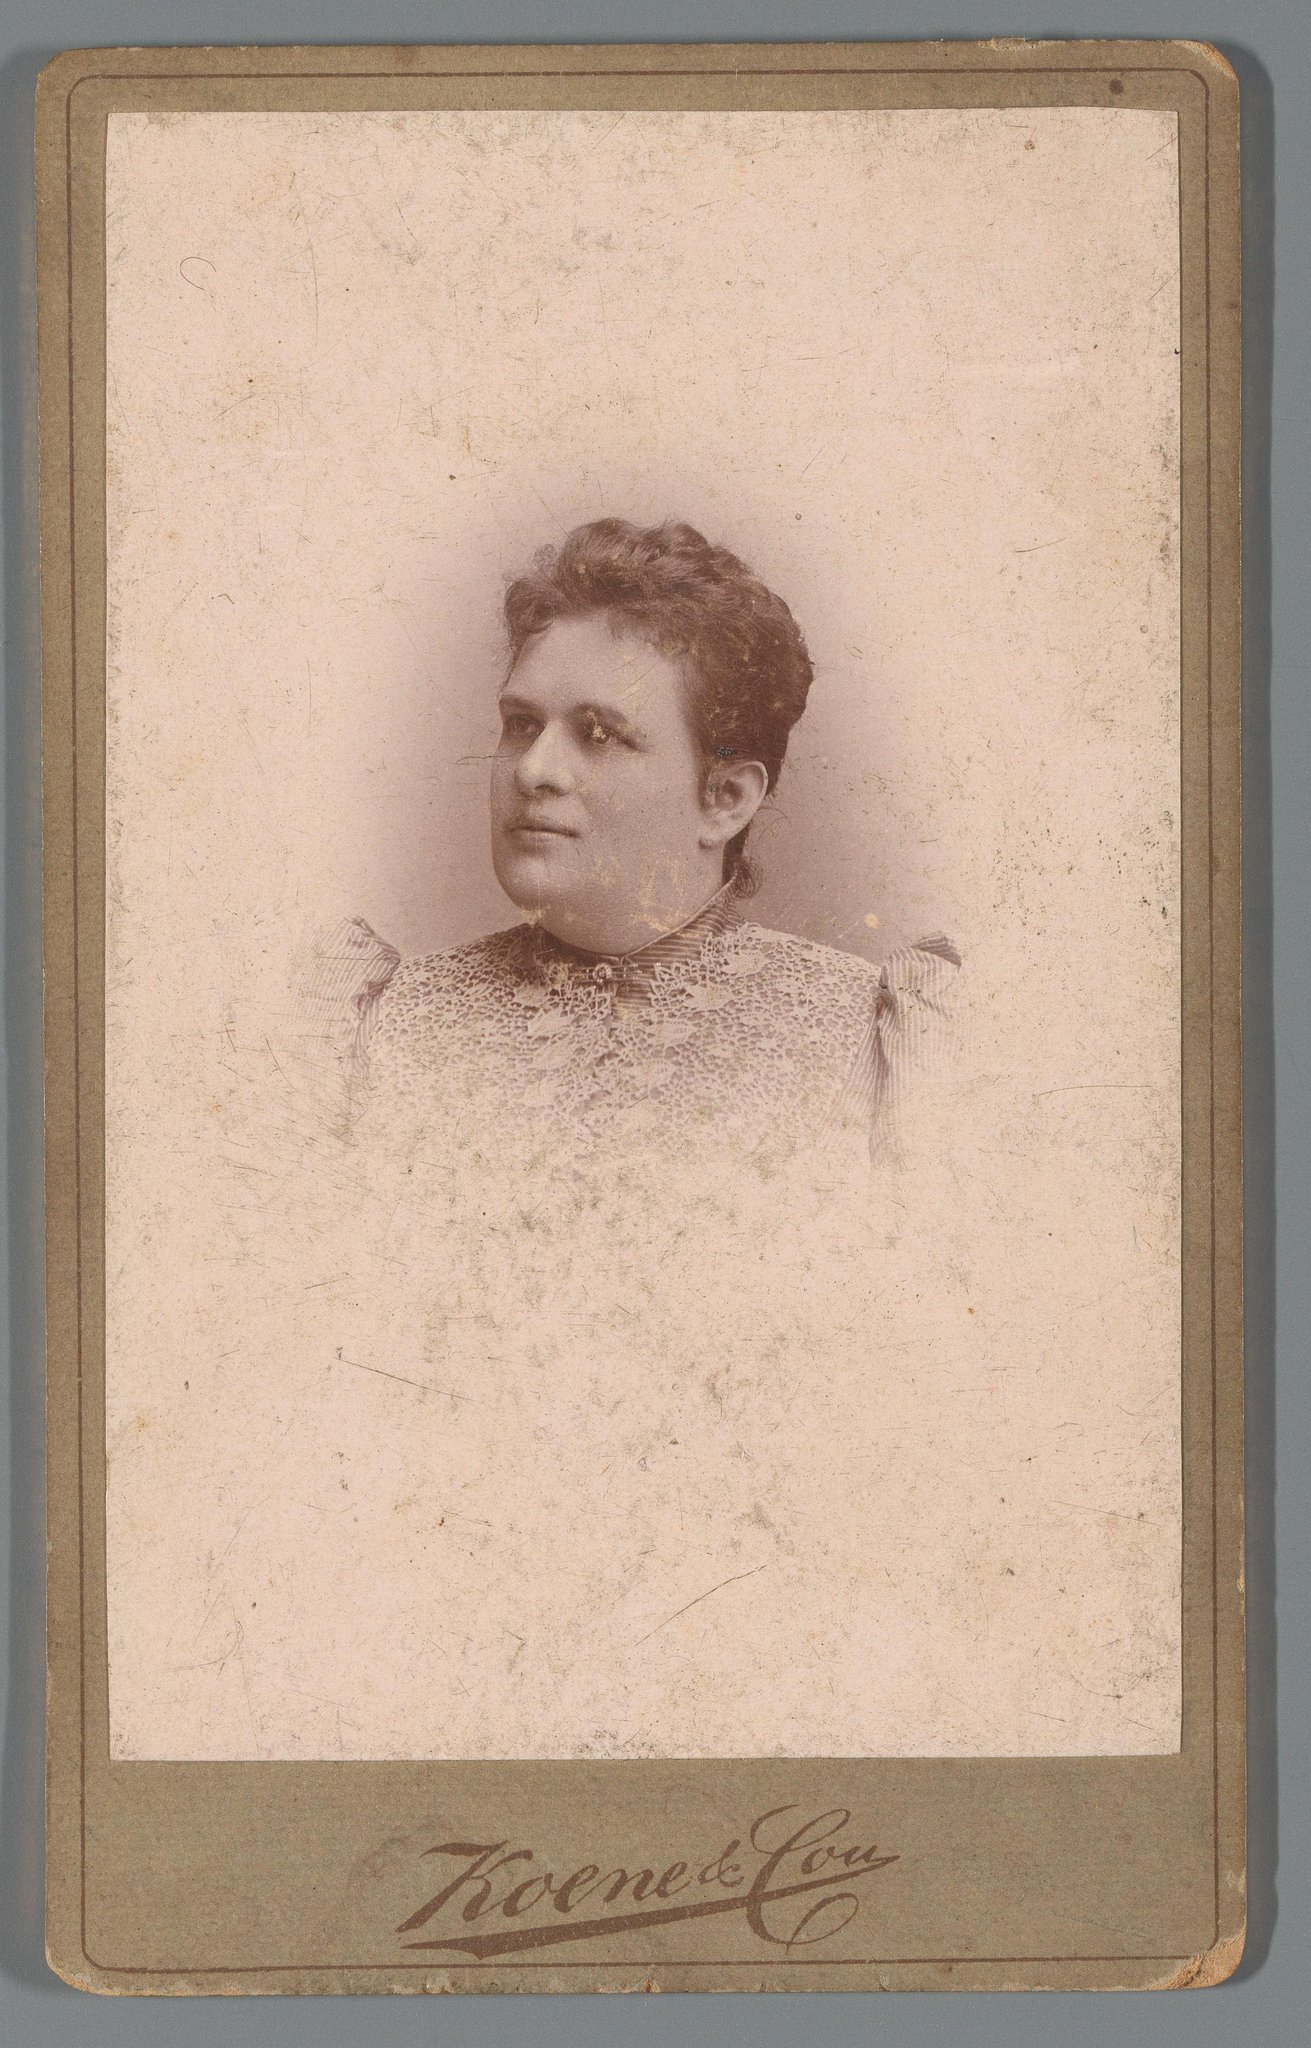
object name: photograph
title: Studioportret van Francina Schas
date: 1802-1893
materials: cardboard, photographic support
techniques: albumen print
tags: francina schas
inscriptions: name: ‘BATAVIA / Koene & Co / AMSTERDAM / ALKMAAR.’, name: ‘Koene & Co’, name: ‘Febr. 93 / Françoise v.d. Berg / Schas’